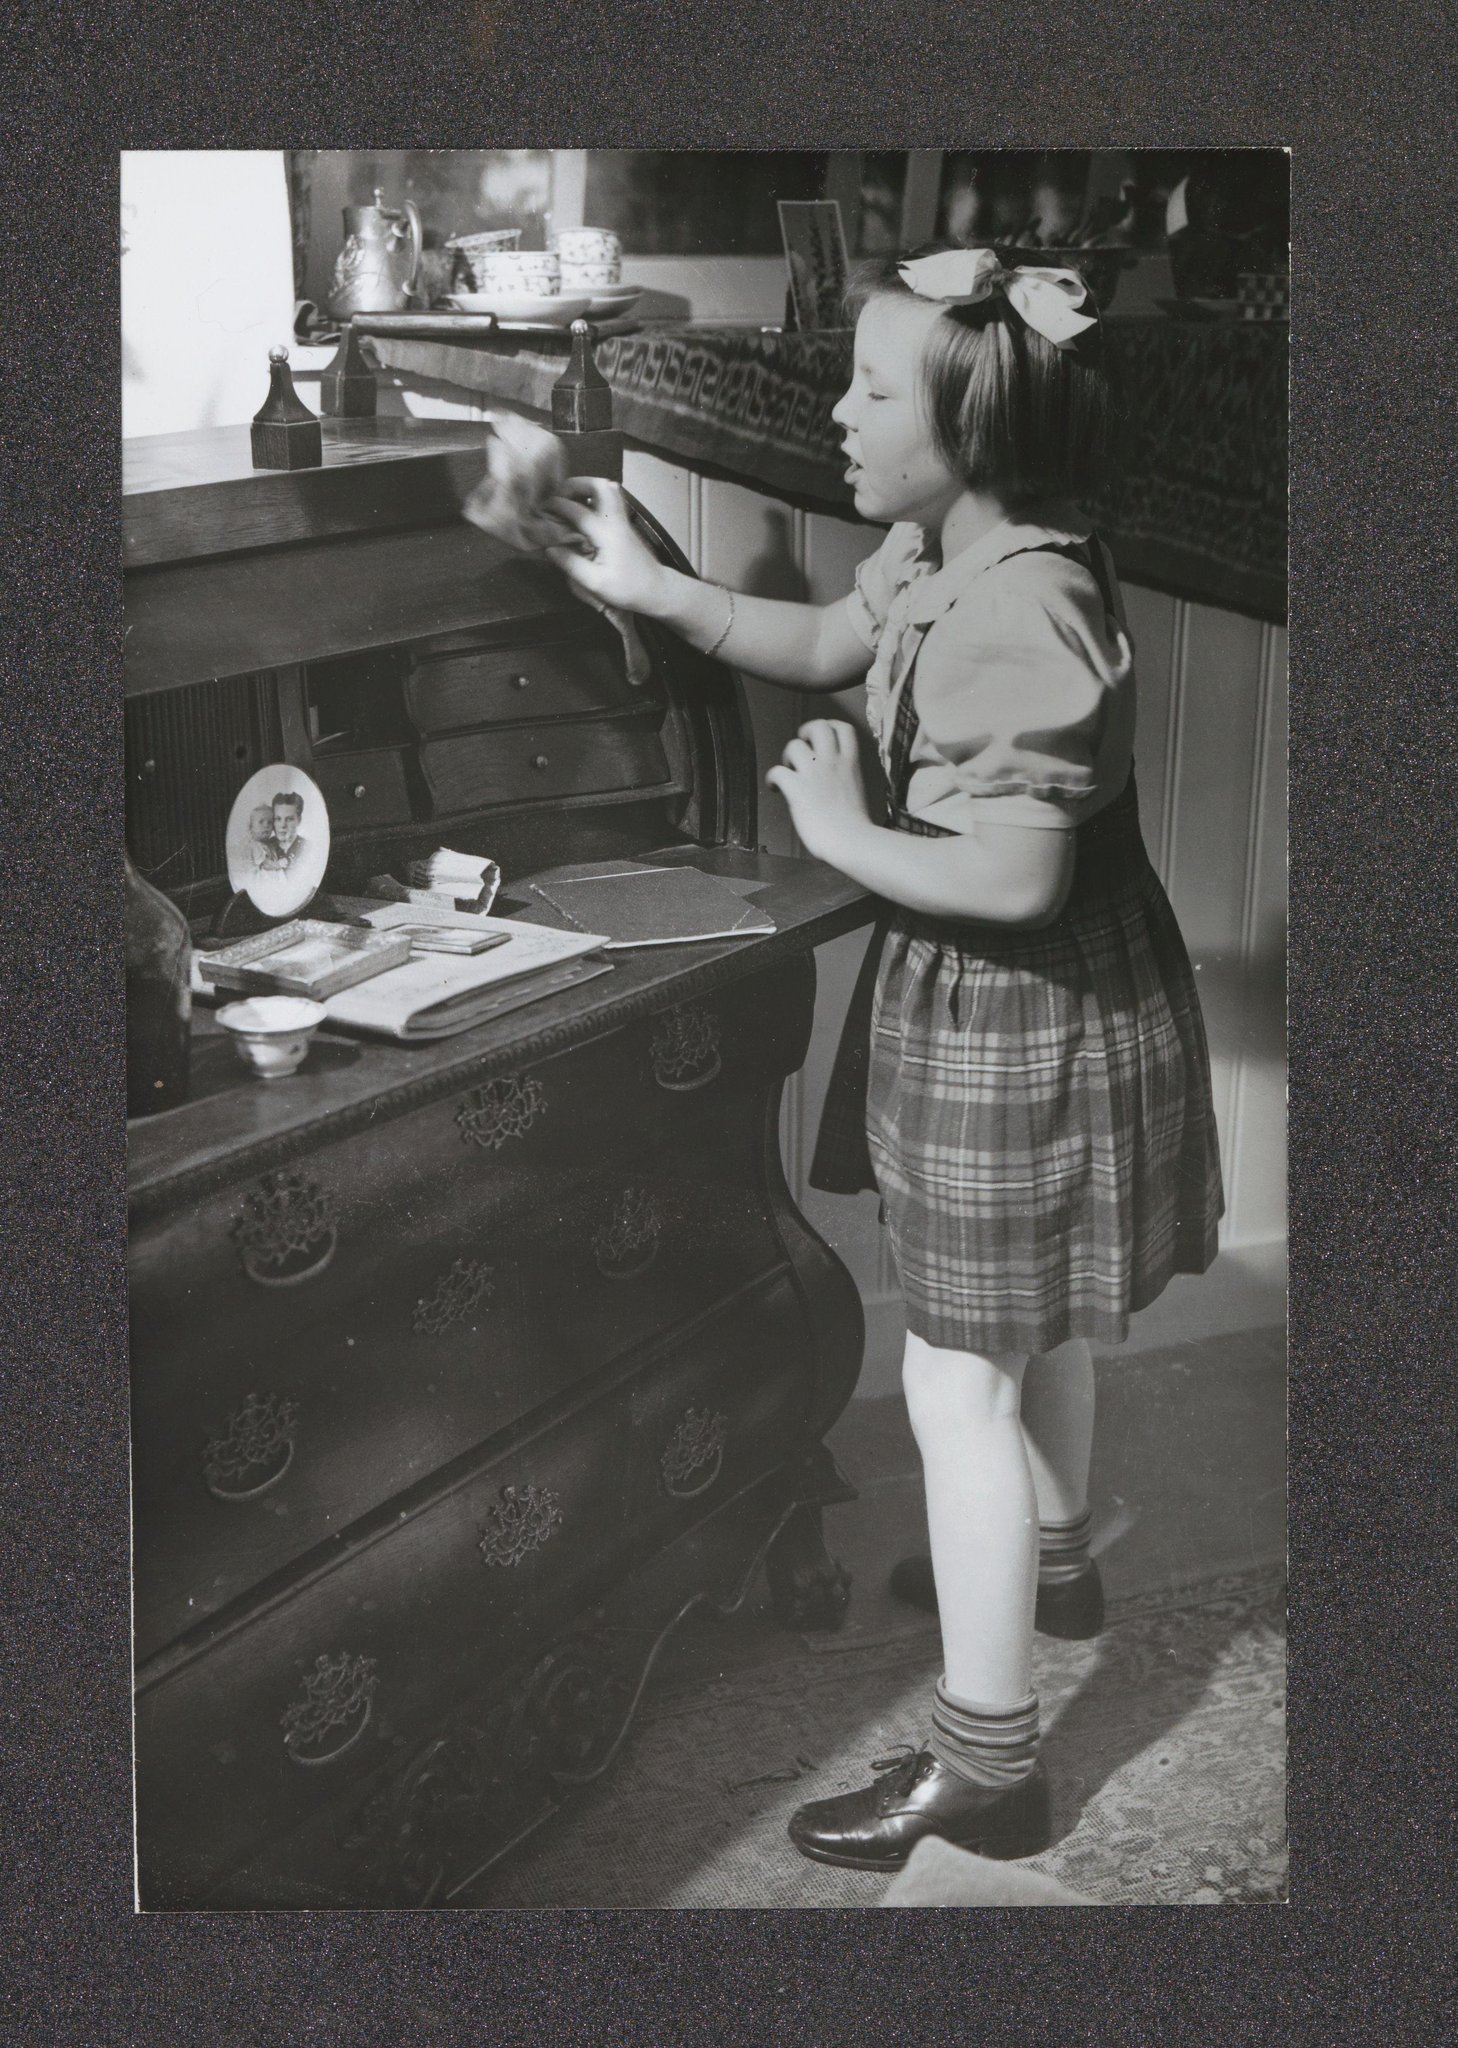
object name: photograph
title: Prinses Beatrix op de school "Kinder Werkplaats" van Kees Boeke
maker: Anonymous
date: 1945-1950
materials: paper, photographic support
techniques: gelatin silver print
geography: netherlands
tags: beatrix (koningin der nederlanden), historical persons - bb - woman, crown princess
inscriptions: annotation: ‘Pr. Beatrix op de school / van Kees Boeken’